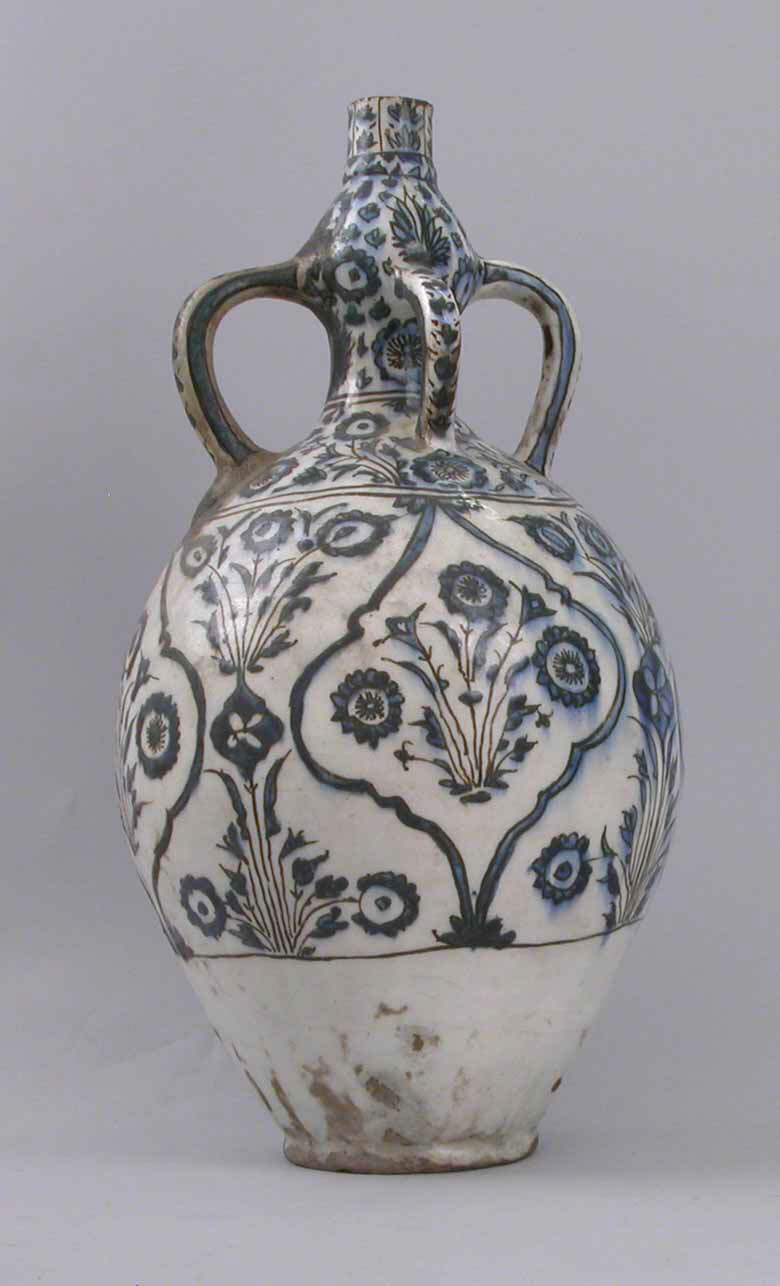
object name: vase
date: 1601-1650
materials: stonepaste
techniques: painting, underglaze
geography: iran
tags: flowers